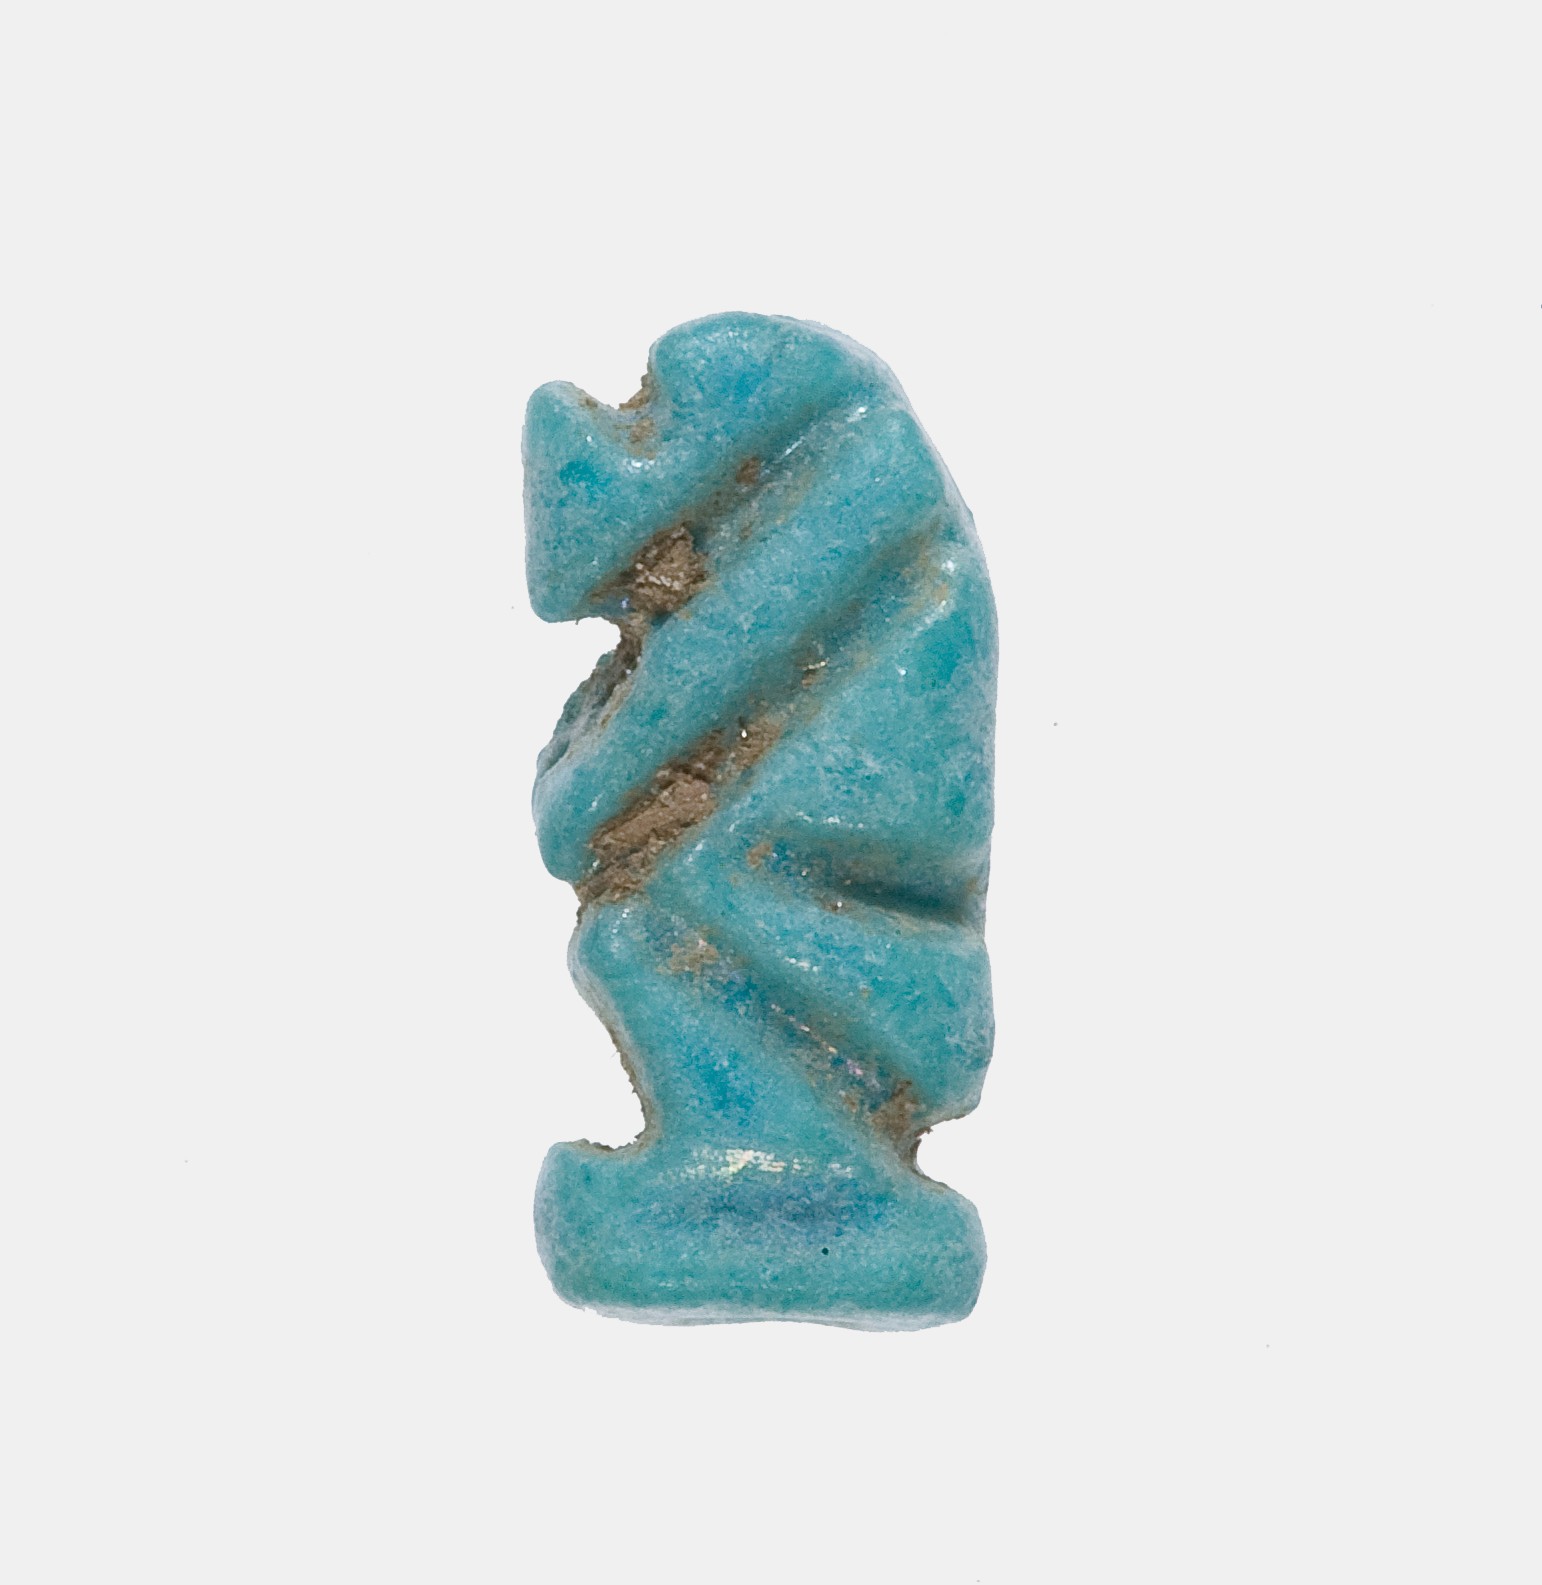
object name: amulet, monkey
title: Monkey Amulet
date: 1802-1450 BCE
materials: faience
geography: egypt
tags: monkeys